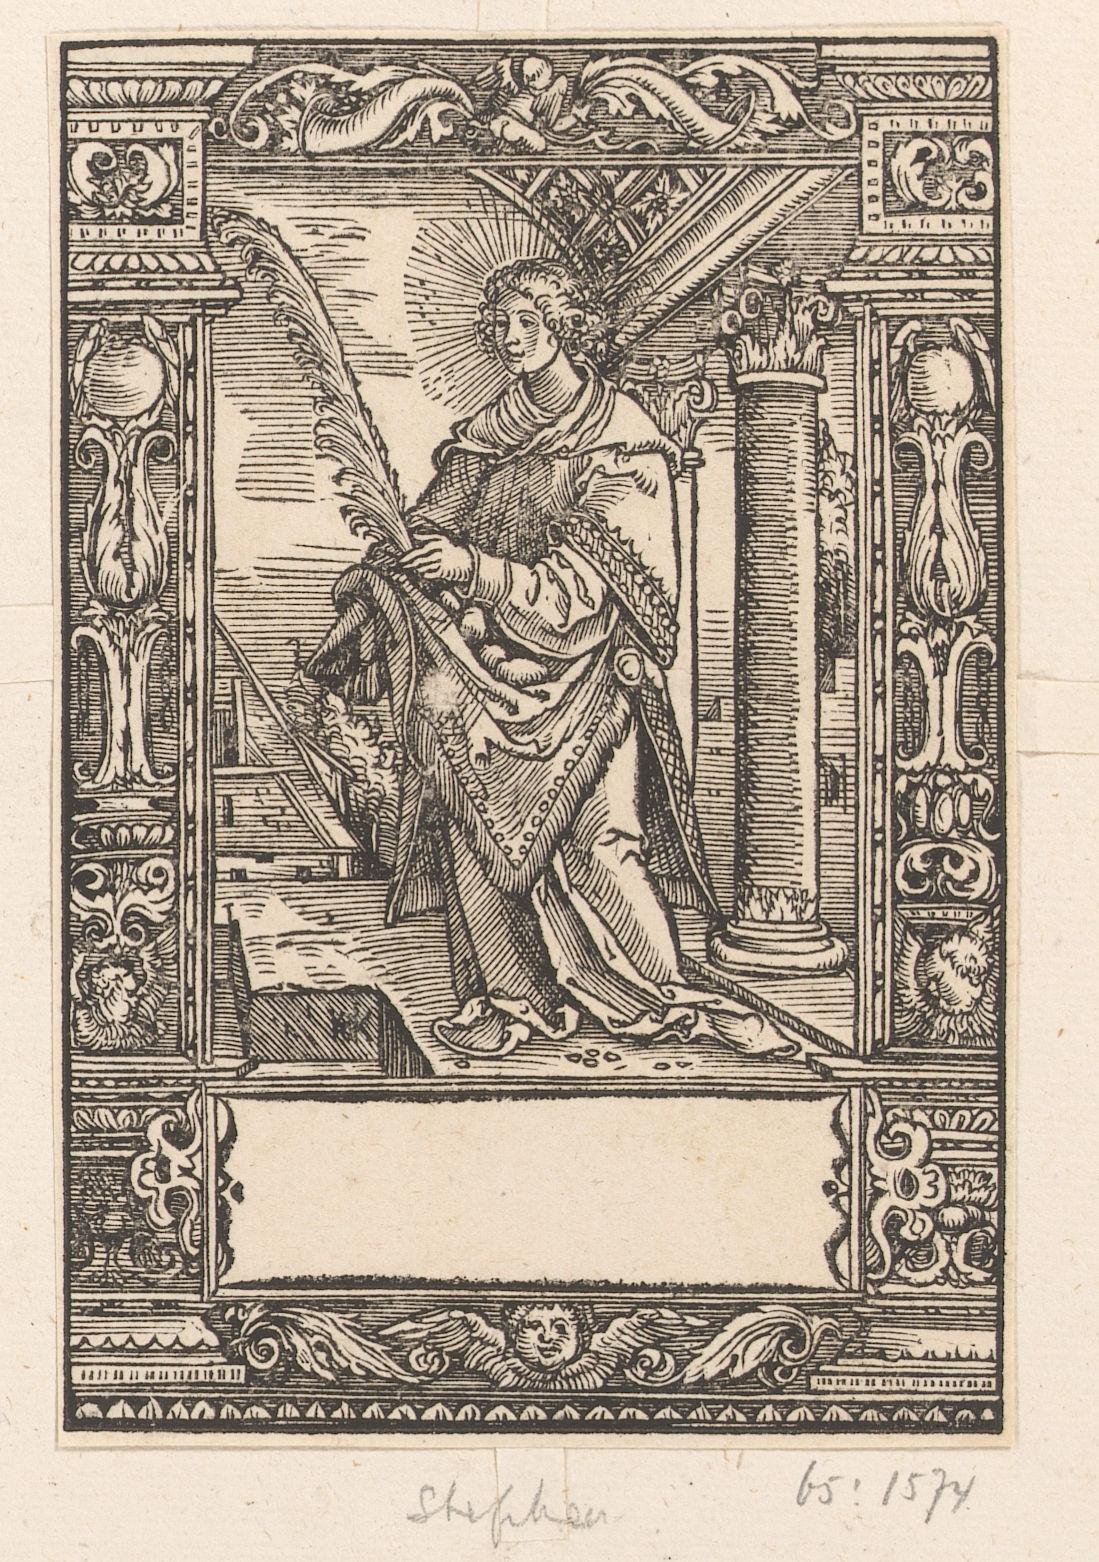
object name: album leaf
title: Hortulus Anime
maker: hans springinklee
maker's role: print maker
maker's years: -1540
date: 1518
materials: paper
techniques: woodcut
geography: nuremberg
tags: the deacon and (proto)martyr stephen; possible attributes: censer, stones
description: Boekillustratie voor: Hortulus Anime. Neurenberg: F. Peypus voor J. Koberger, 1518.